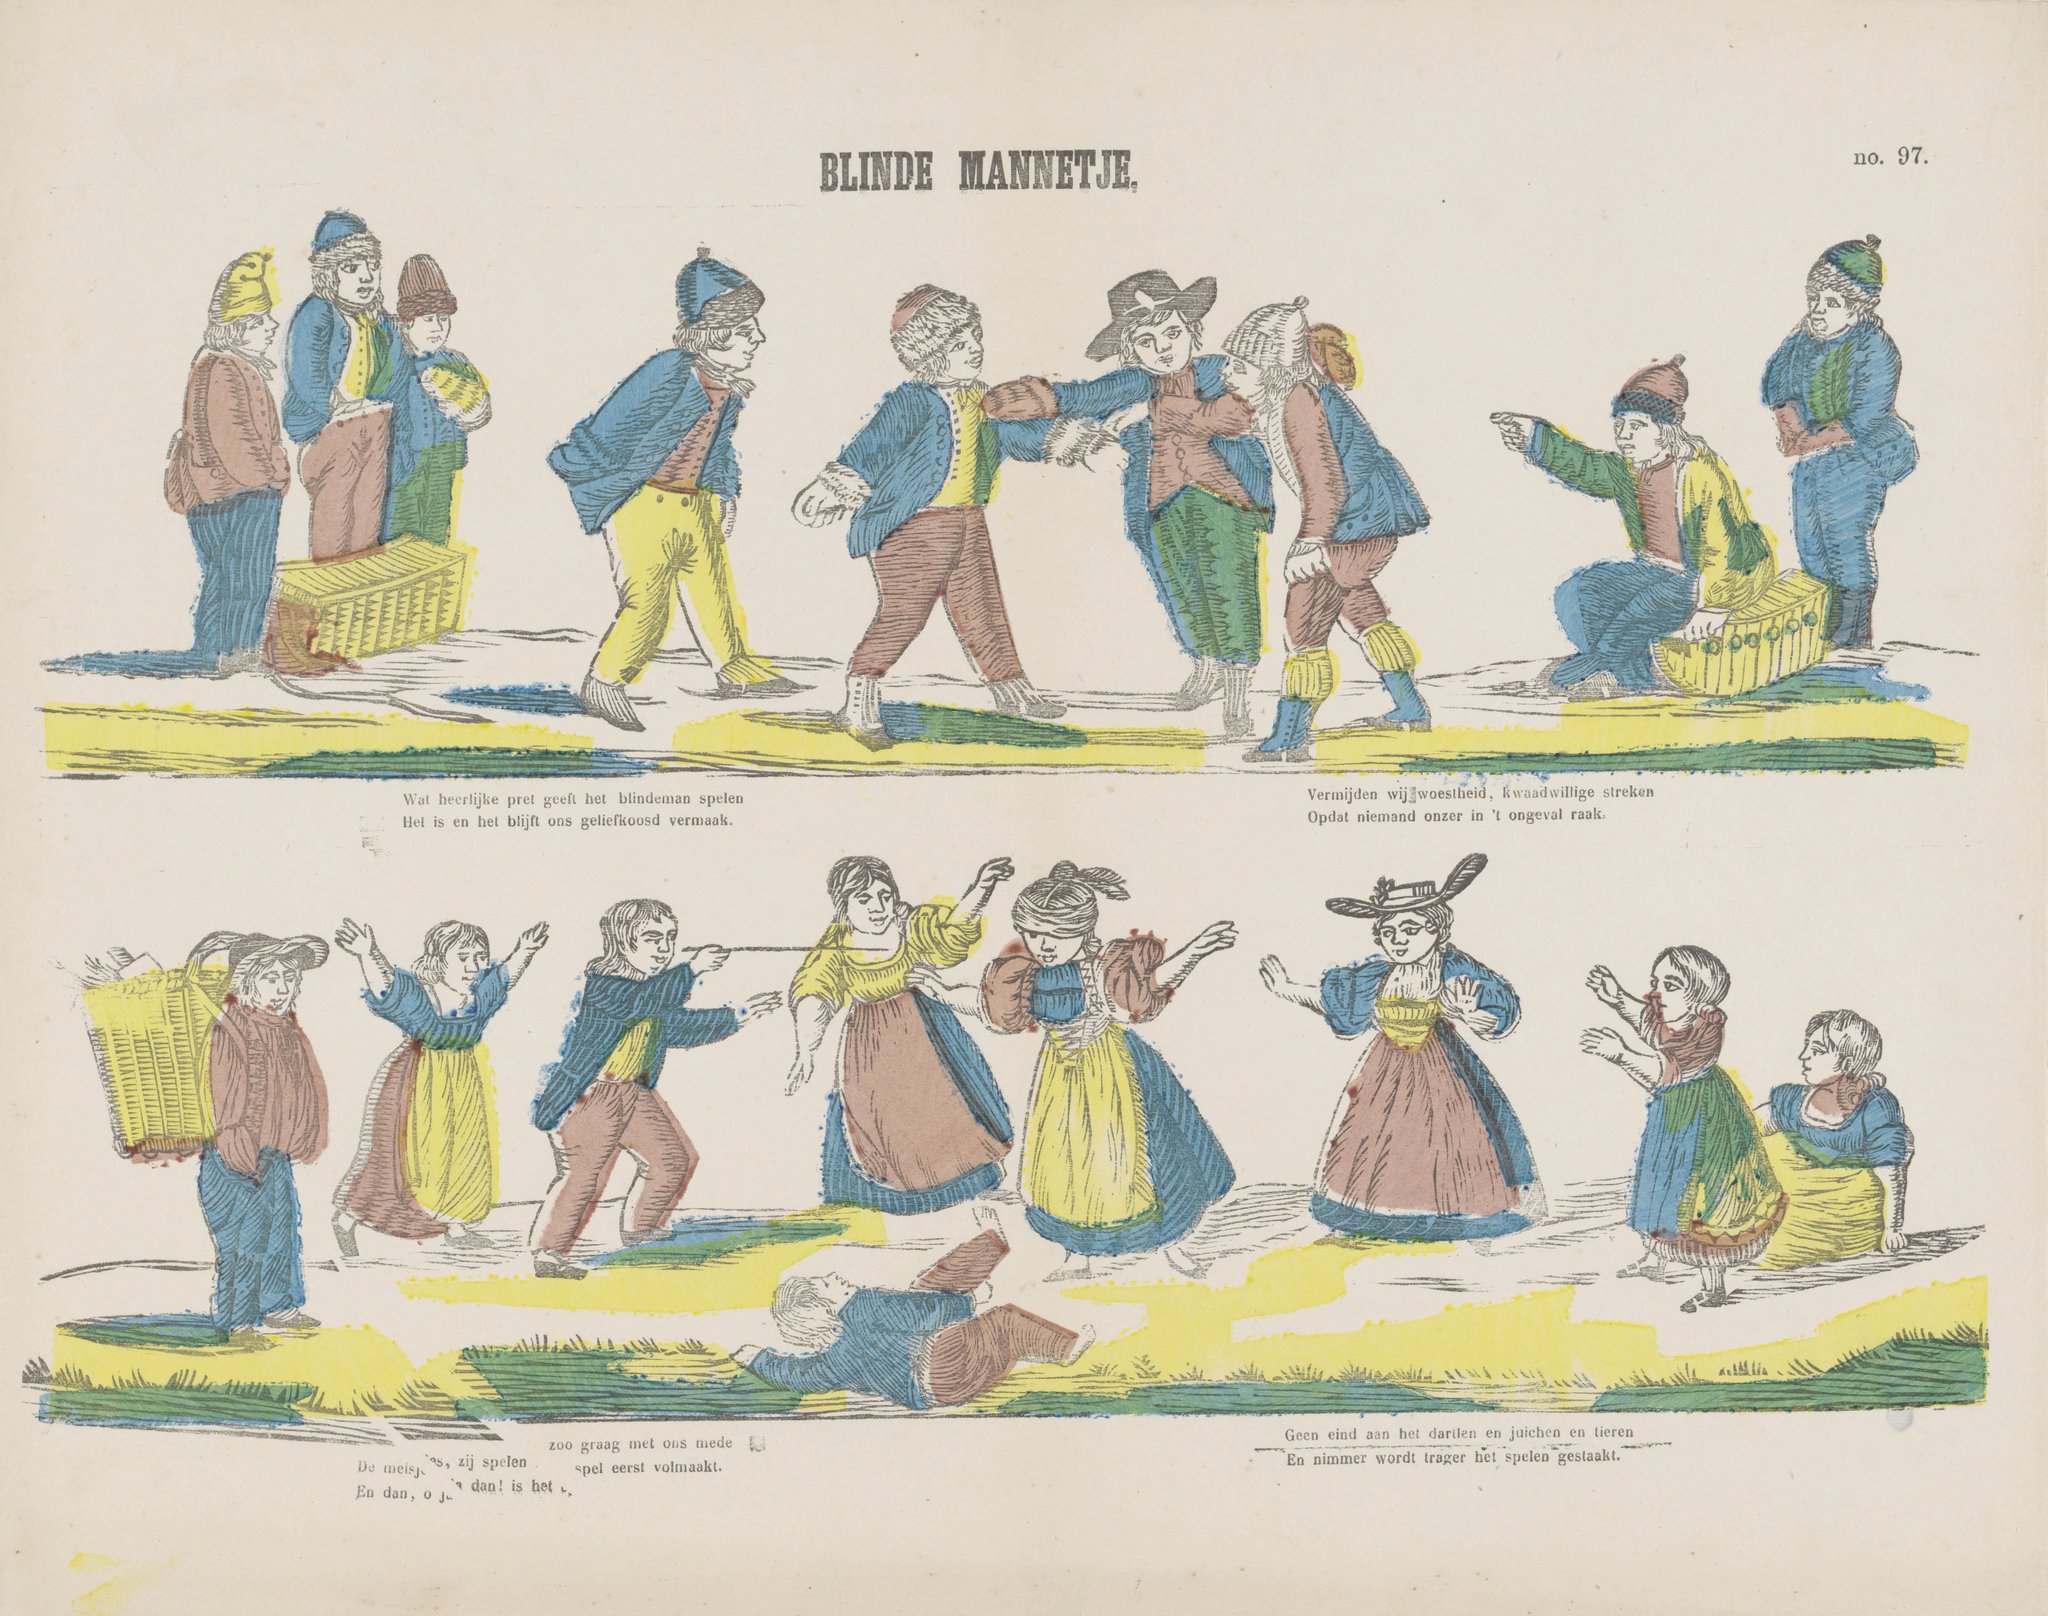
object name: popular print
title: Blinde mannetje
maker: Anonymous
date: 1848-1881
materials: paper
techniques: colour, letterpress printing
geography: den bosch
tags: blind-man's buff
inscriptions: collector's mark: Lugt 2760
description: Blad met 2 voorstellingen van het kinderspel blindemannetje. Onder elke afbeelding een vierregelig vers in twee kolommen. Rechtsboven genummerd: no. 97.